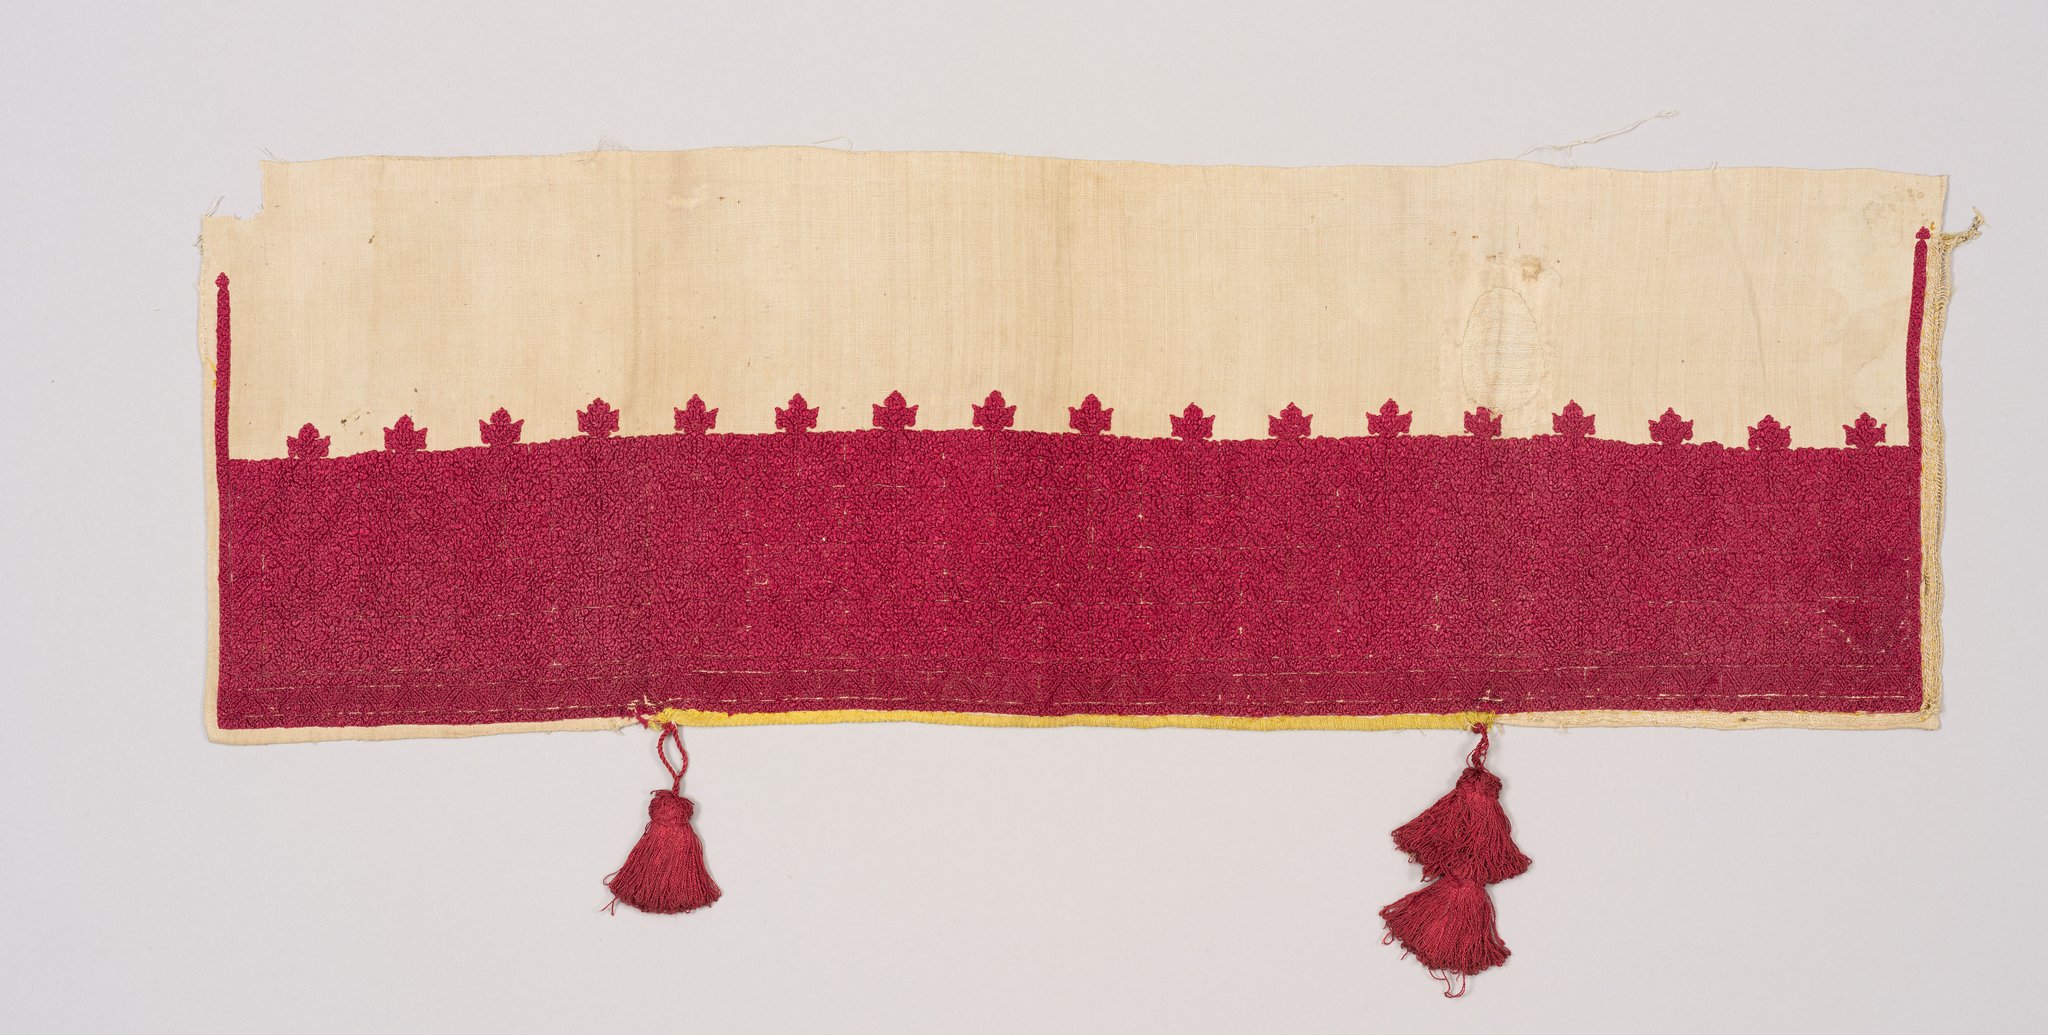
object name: scarf end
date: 1767-1800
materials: wool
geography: morocco